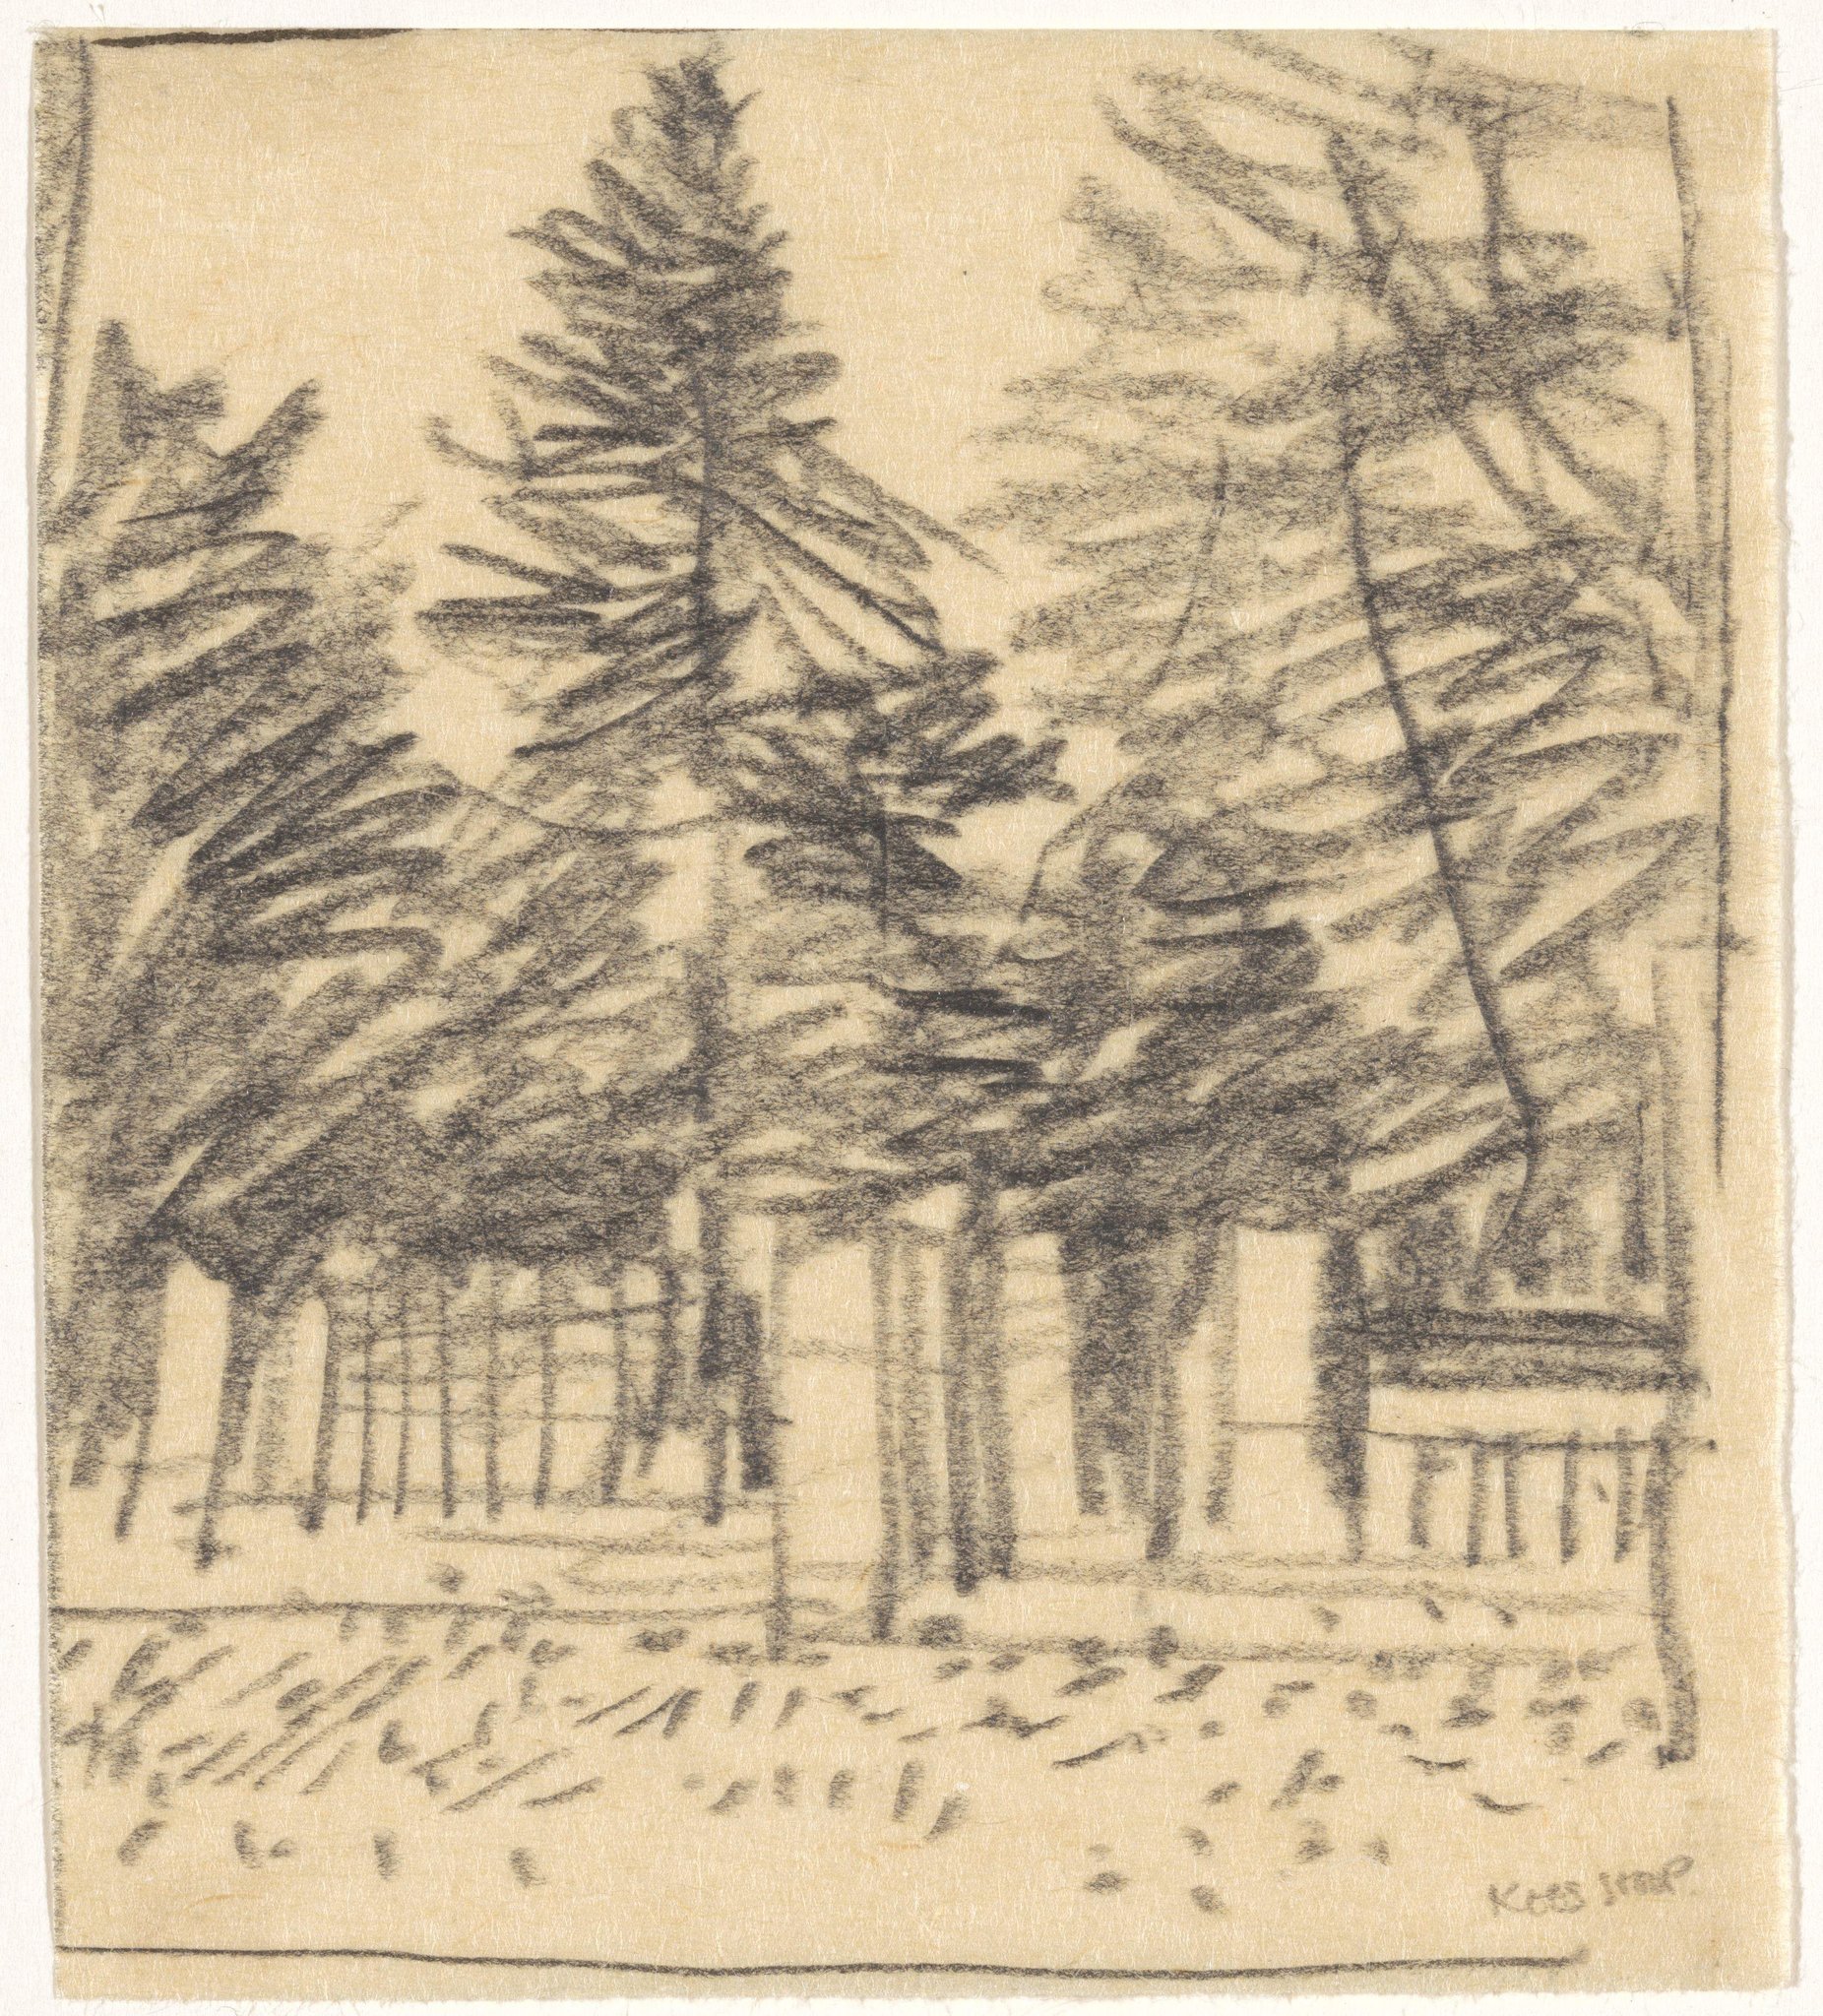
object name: drawing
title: Hek voor bomen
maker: kees stoop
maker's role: draughtsman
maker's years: 1929-2019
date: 1939-2009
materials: paper, pencil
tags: fence, wall, paling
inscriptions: signature: ‘Kees Stoop’